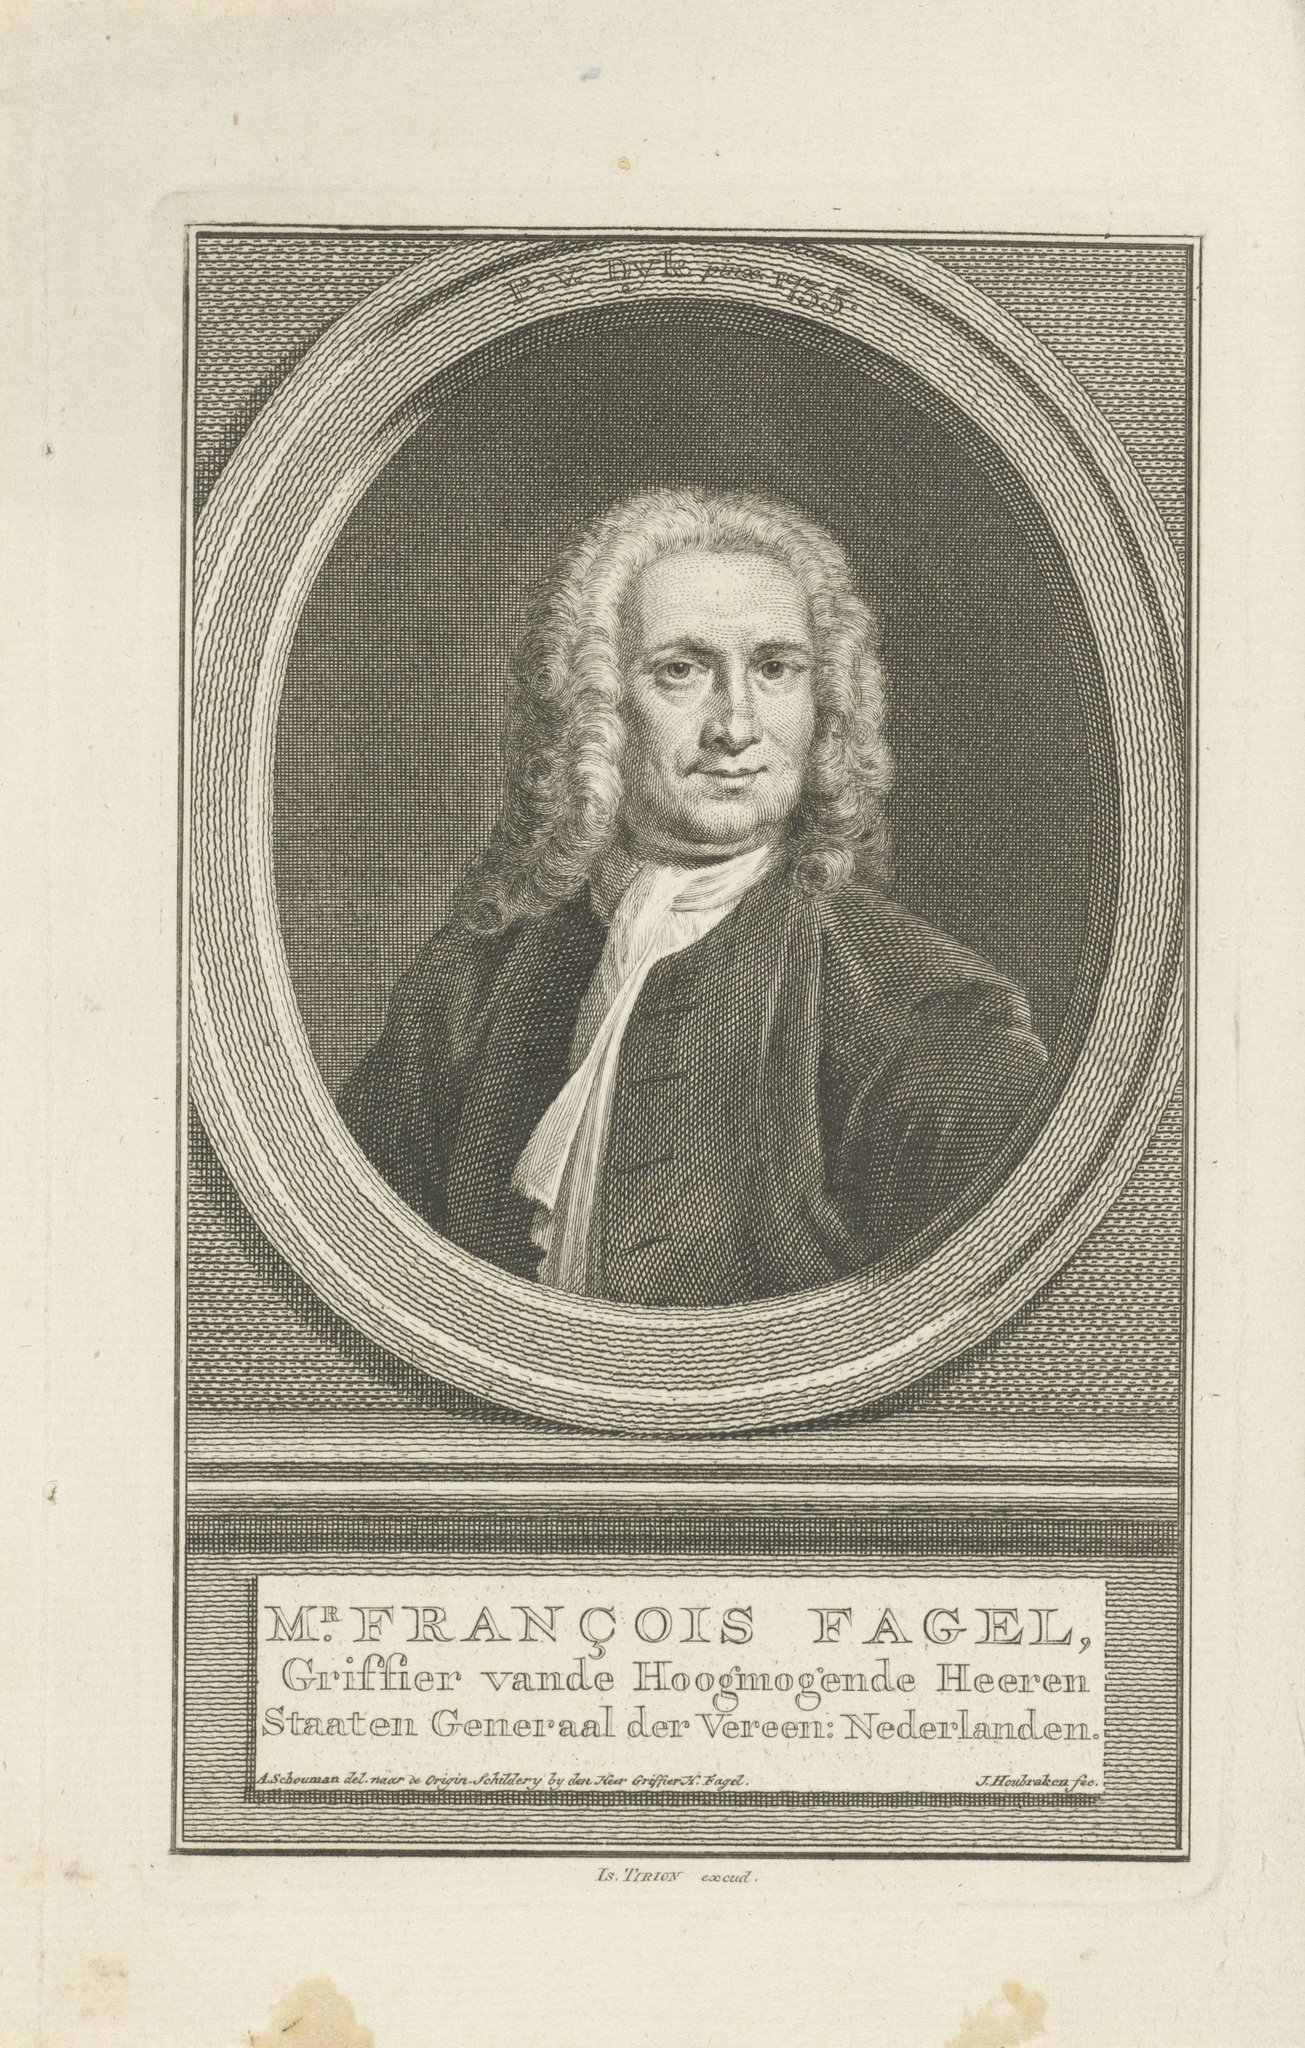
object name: print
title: Mr. François Fagel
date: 1749-1759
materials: paper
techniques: engraving, etching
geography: amsterdam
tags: the hague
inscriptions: collector's mark: Lugt 2228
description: Prent ook gebruikt in: Jan Wagenaar, Vaderlandsche historie, vervattende de geschiedenissen der nu Vereenigde Nederlanden, inzonderheid die van Holland (...), 21 delen. Amsterdam, Isaak Tirion, 1749-59.